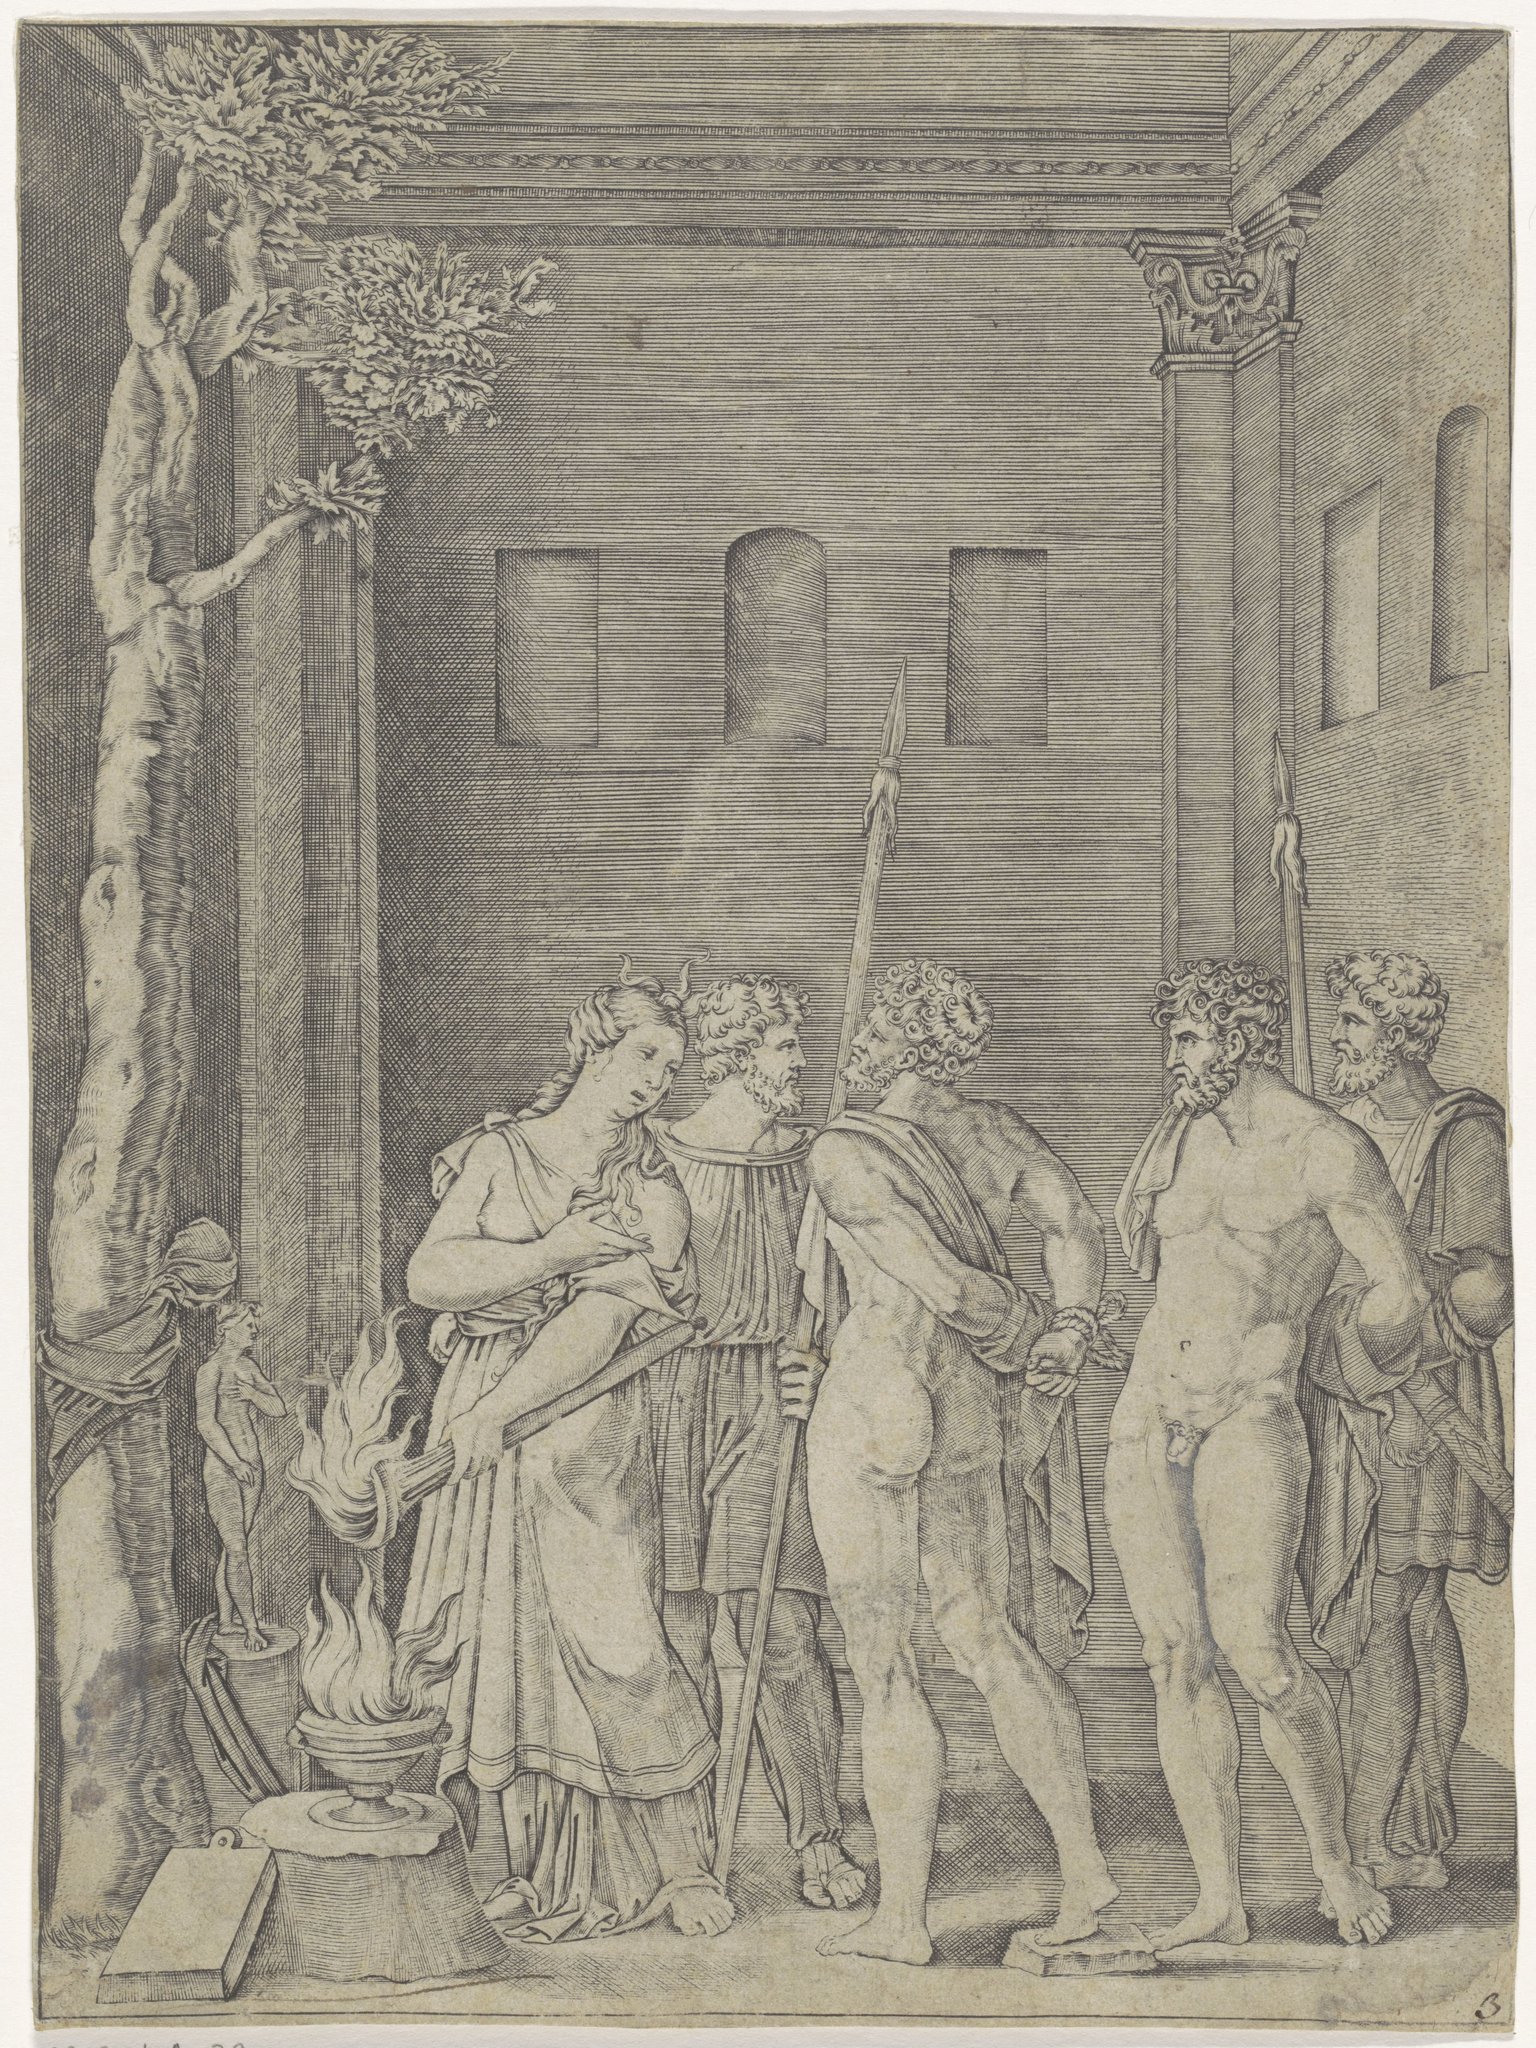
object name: print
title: Iphigenia herkent Orestes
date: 1500-1536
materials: paper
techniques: engraving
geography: italy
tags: iphigenia recognizes her brother orestes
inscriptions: number: ‘3’, collector's mark: Lugt 10, collector's mark: Lugt 11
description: Iphigenia, priesteres van Diana, herkent haar broer Orestes en zijn metgezel Pylades. De mannen zijn geboeid om aan Diana te worden geofferd.